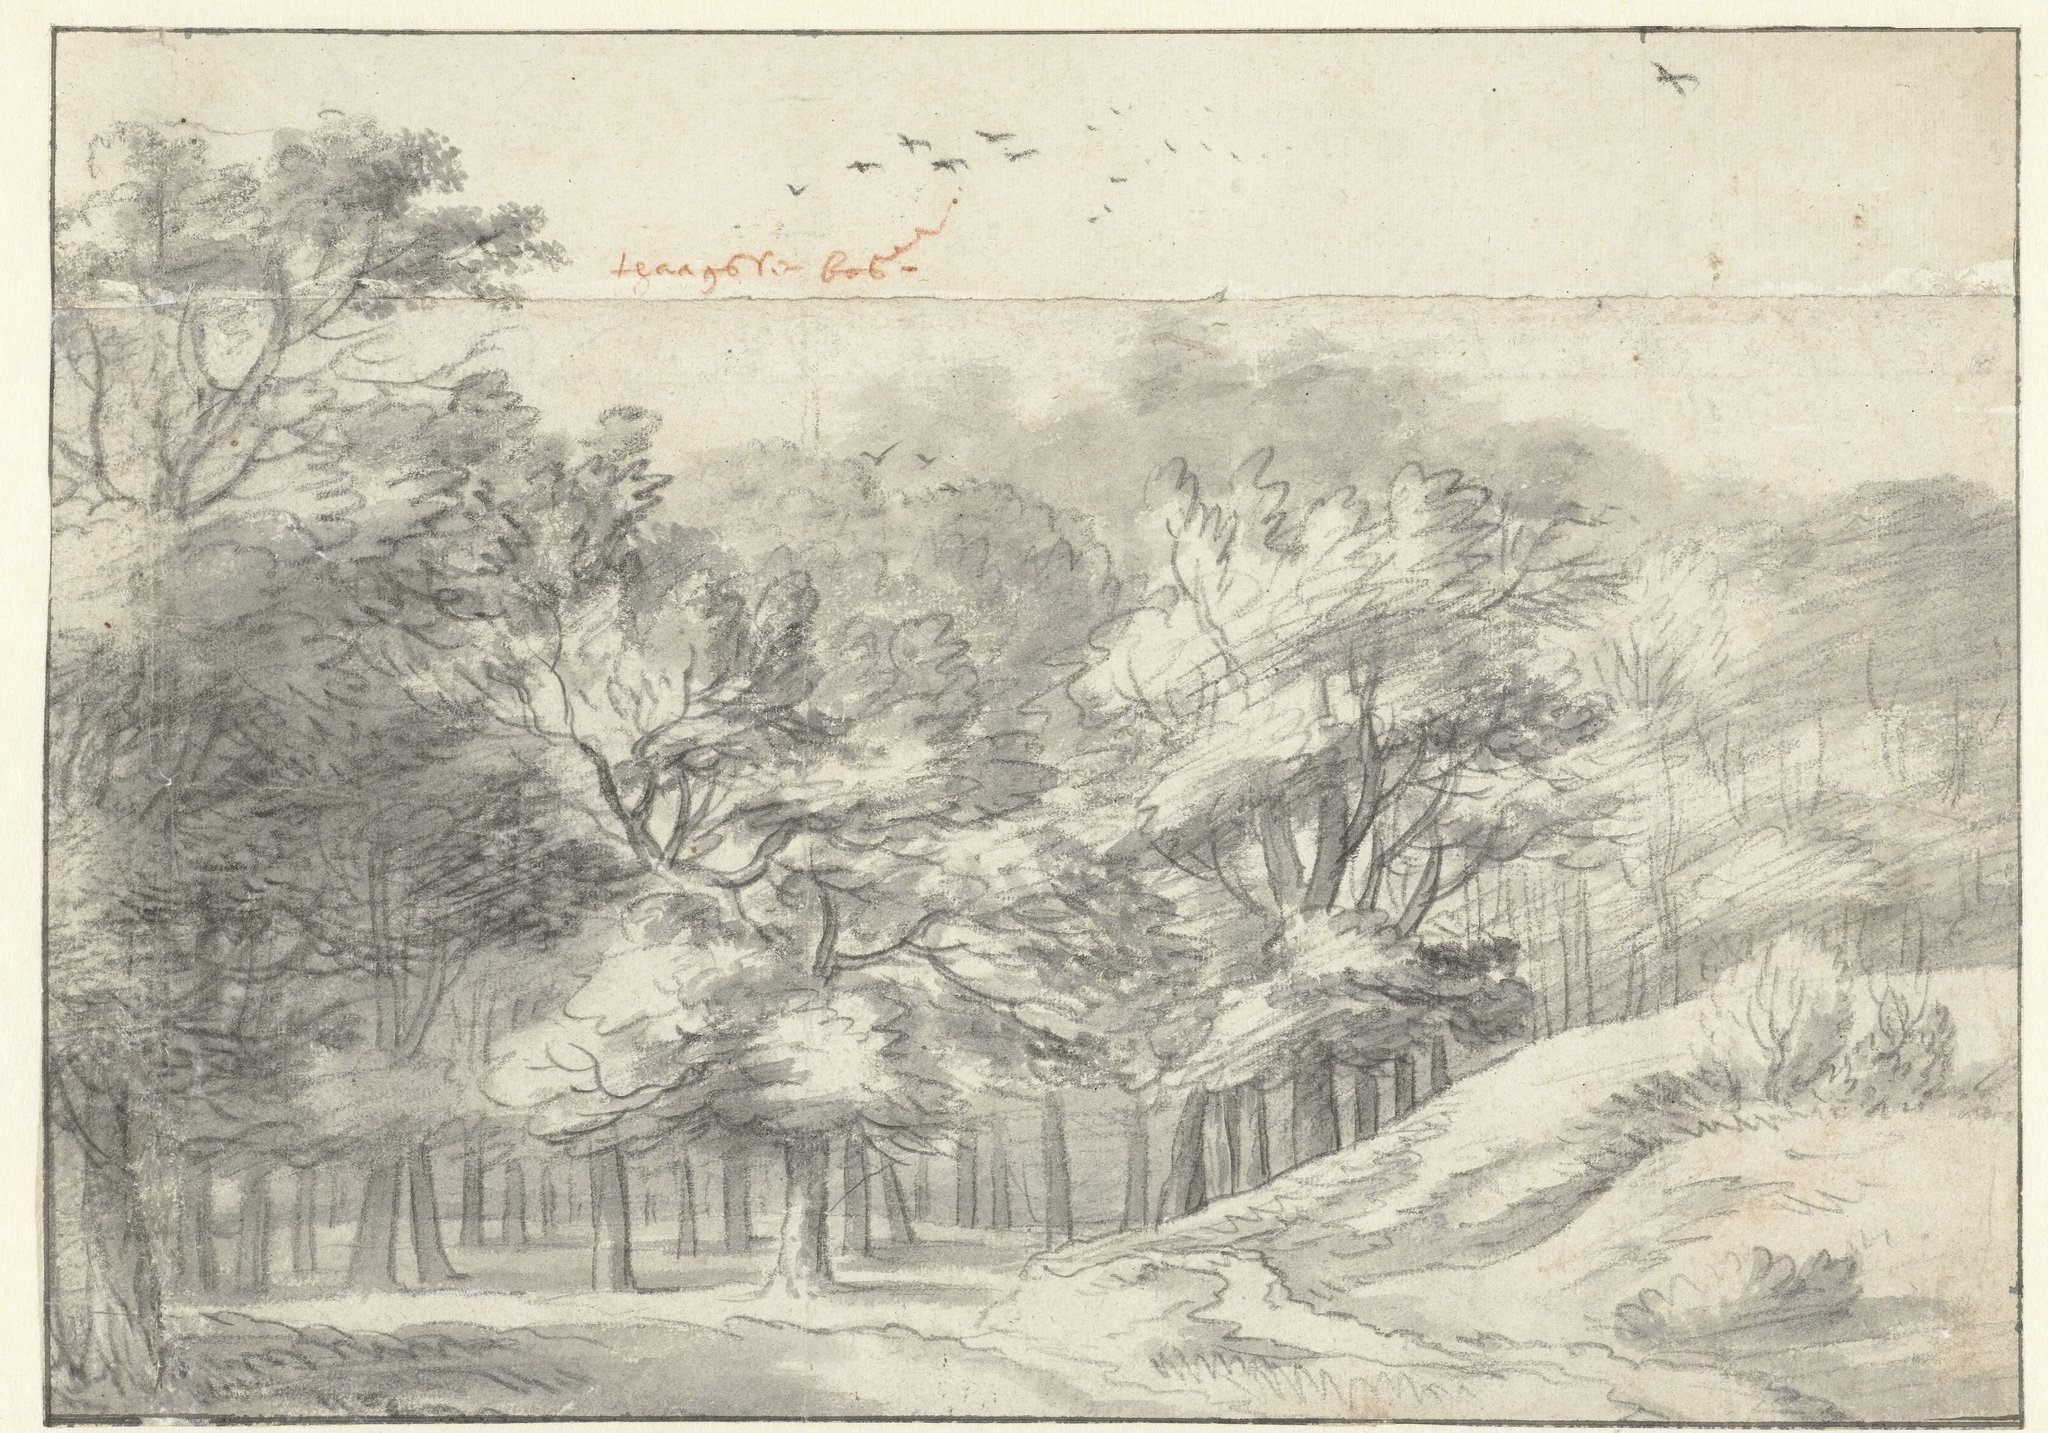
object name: drawing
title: View in the Haagse Bos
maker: roelant roghman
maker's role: draughtsman, painter, print maker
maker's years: 1627-1692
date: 1650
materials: chalk, paper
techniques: brush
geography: the hague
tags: forest, wood